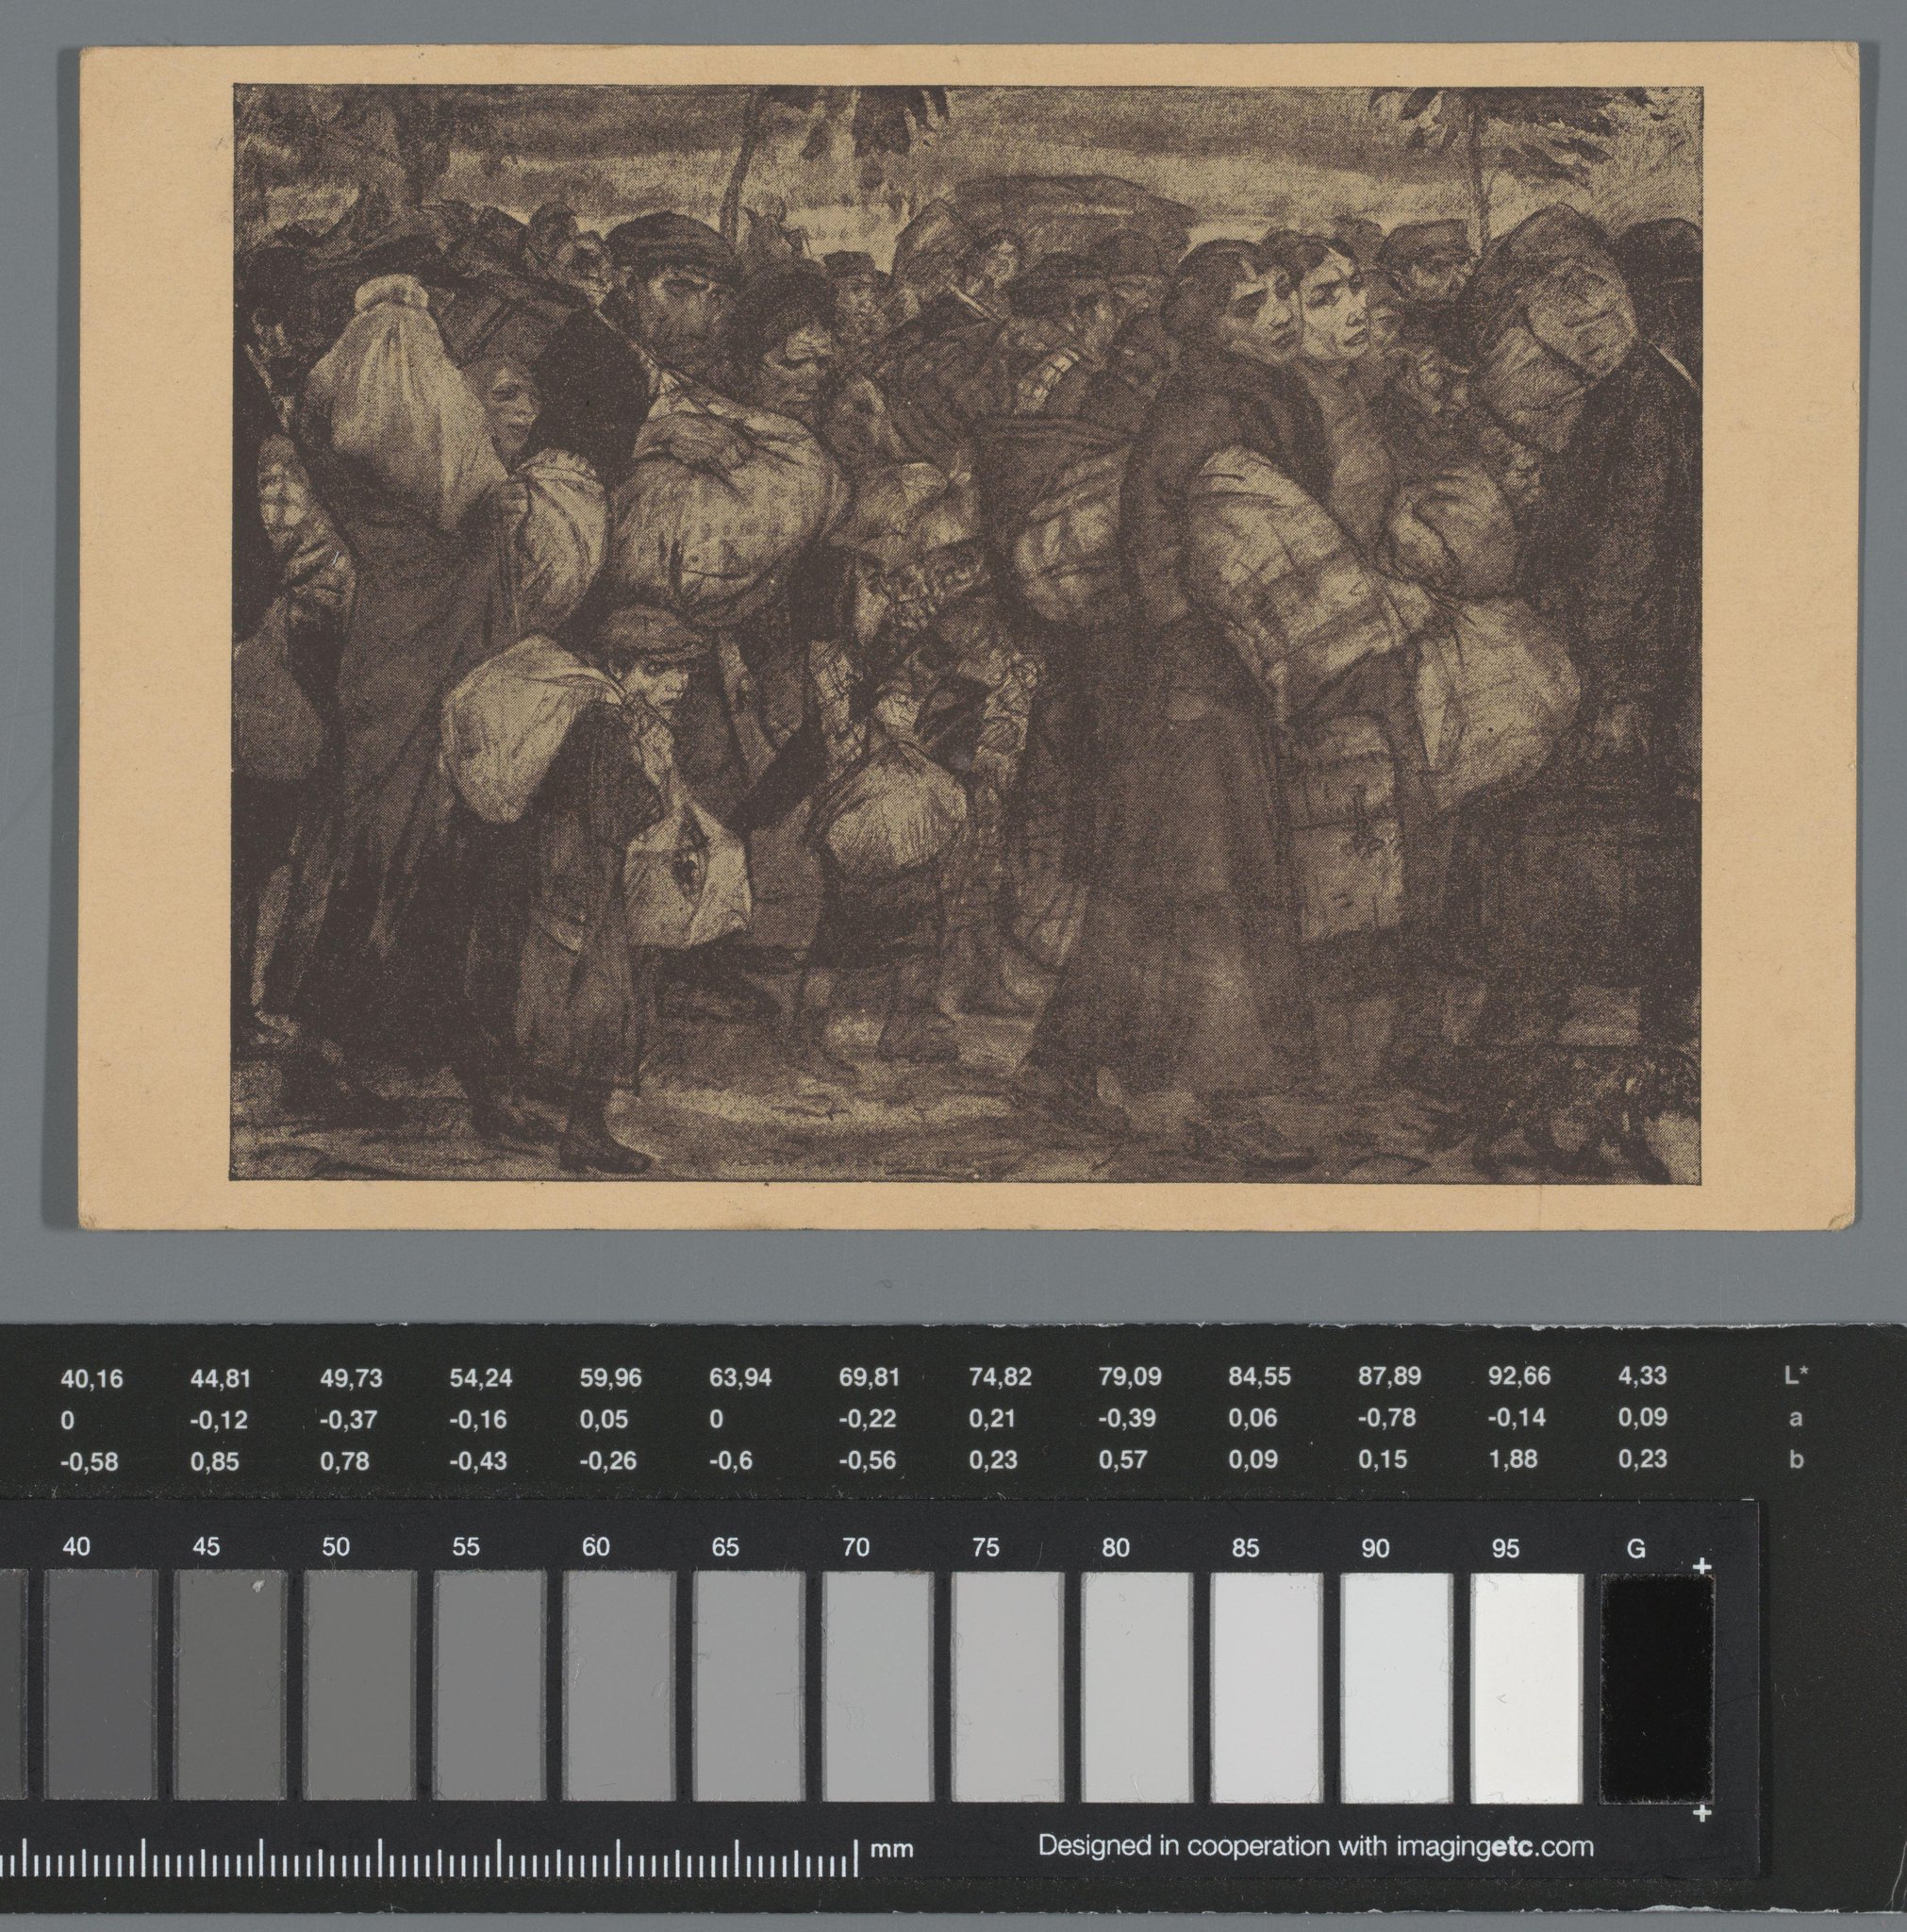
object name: reproduction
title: De vlucht uit België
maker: leo gestel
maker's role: draughtsman, print maker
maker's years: 1881-1941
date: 1914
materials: cardboard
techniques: offset printed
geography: the hague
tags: political refugee, 'émigré', belgium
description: Onbeschreven prentbriefkaart met een voorstelling van een groep vluchtelingen uit België. Prentbriefkaart maakt deel uit van een album.